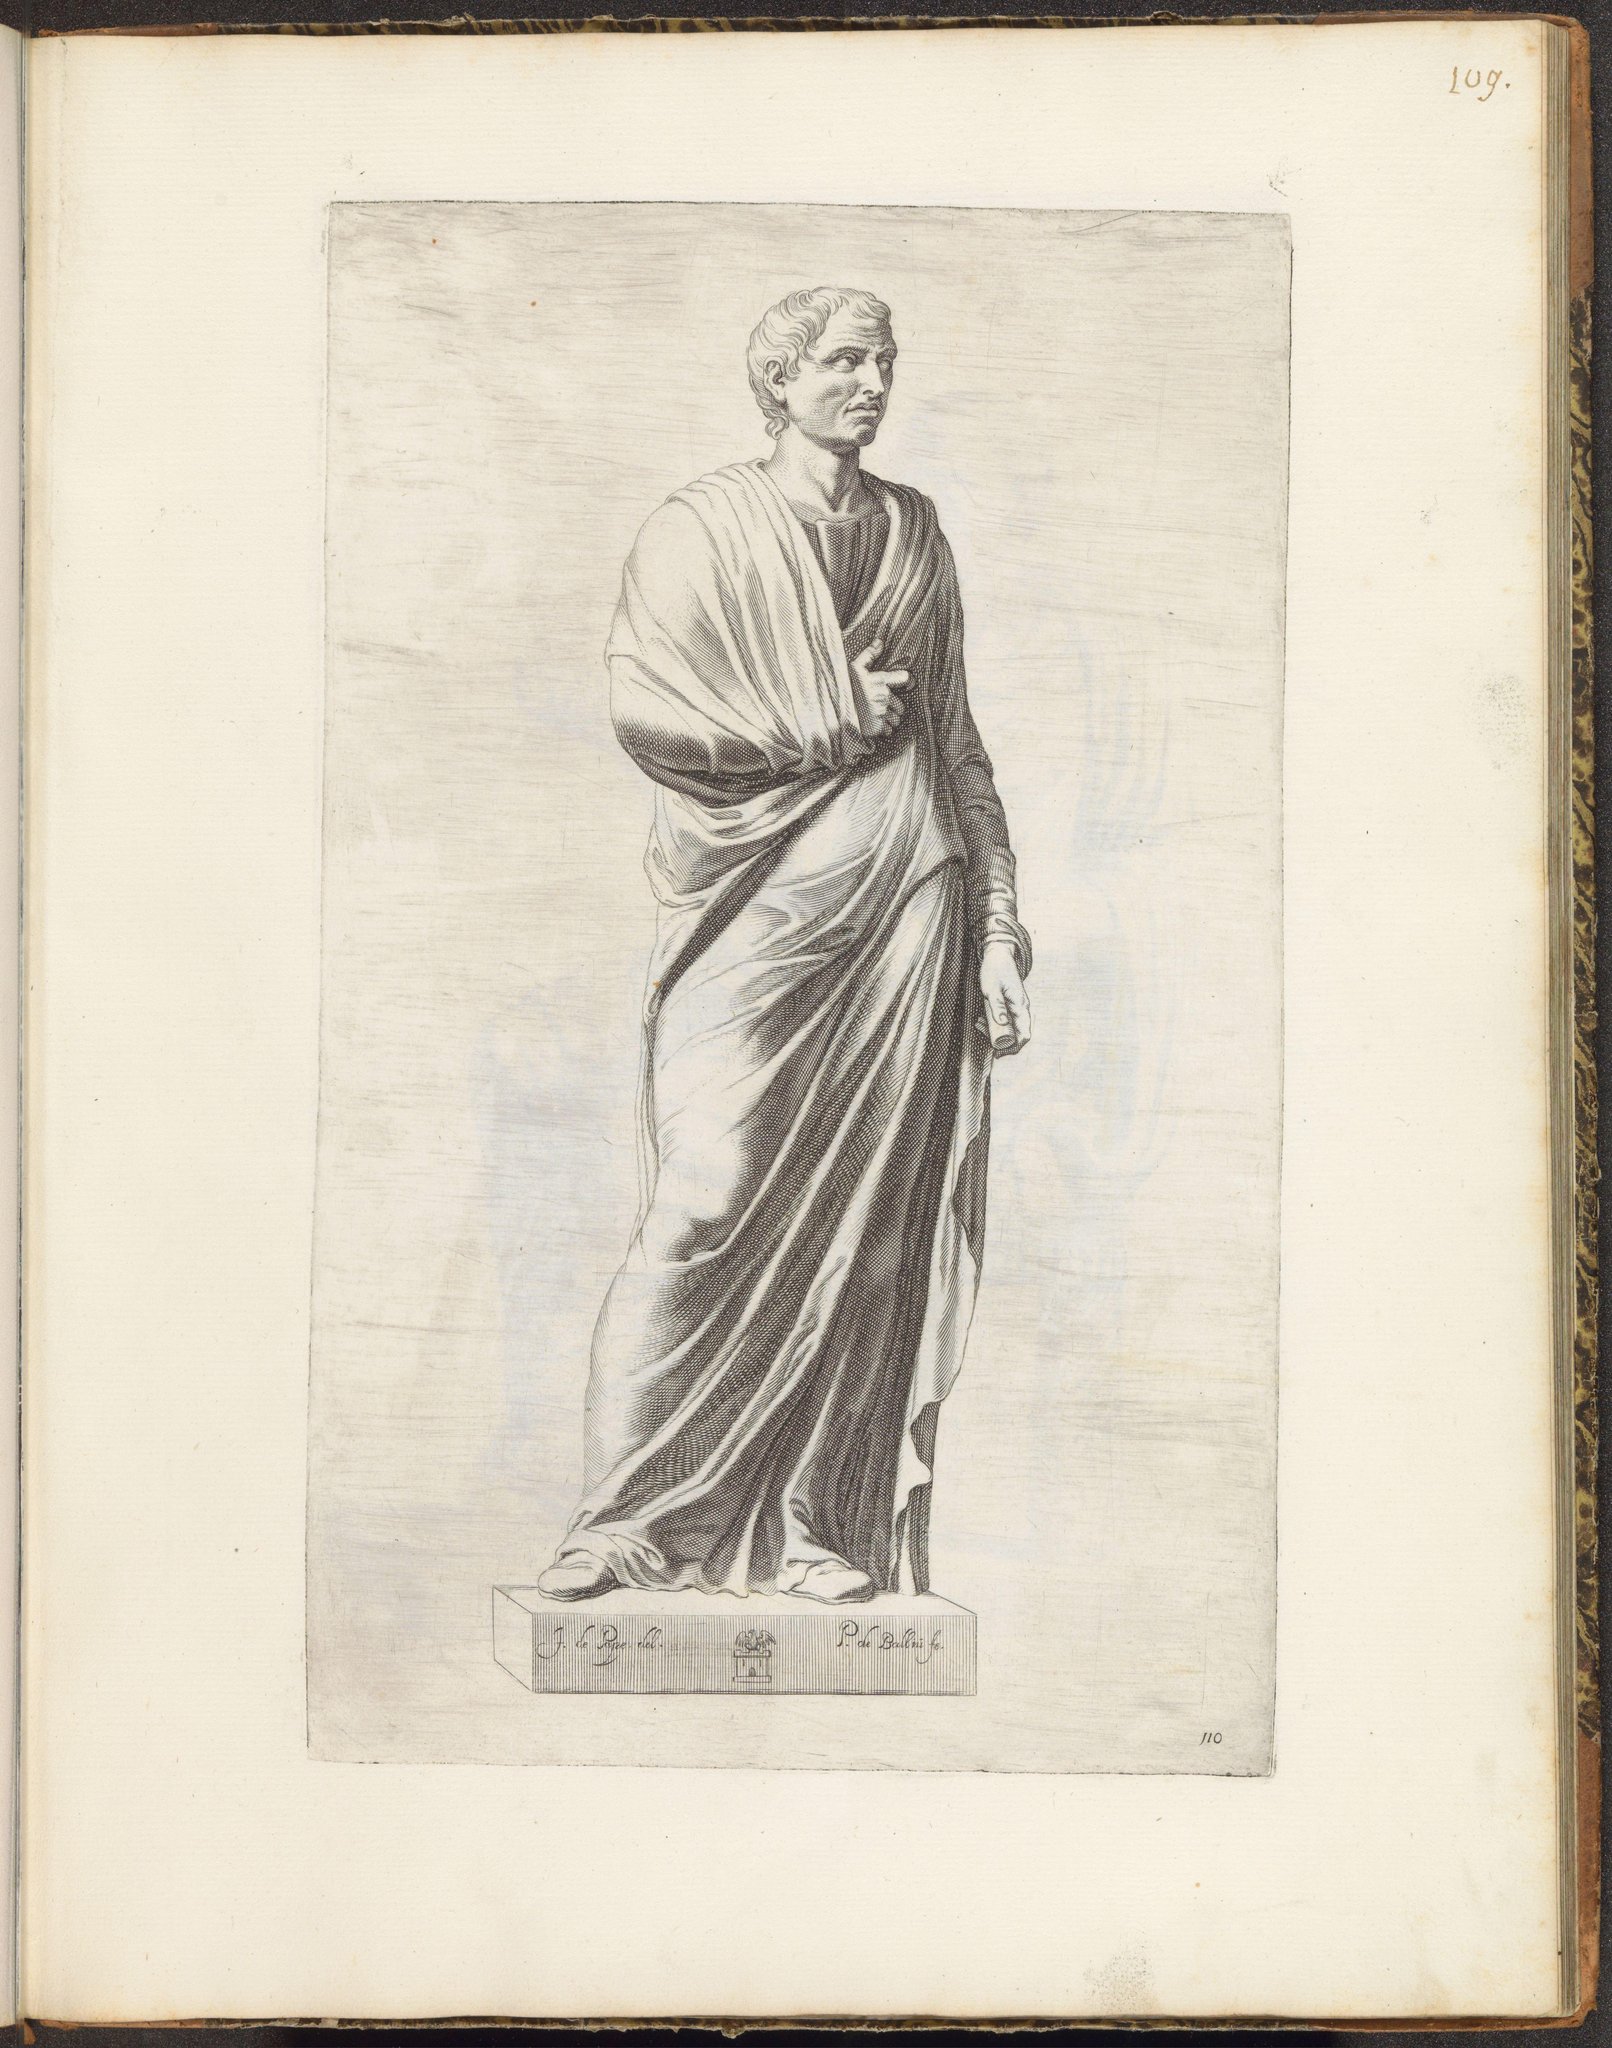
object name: print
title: Standbeeld van een consul in toga met schriftrol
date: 1636-1647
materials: paper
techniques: engraving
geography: rome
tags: piece of sculpture, reproduction of a piece of sculpture, male persons from classical history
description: Standbeeld van een consul in toga met schriftrol. Op de basis het wapenschild van Vincenzo Giustiniani. Prent maakt deel uit van een album met een serie prenten naar de sculpturen in de verzameling in de Galleria Giustiniani te Rome.